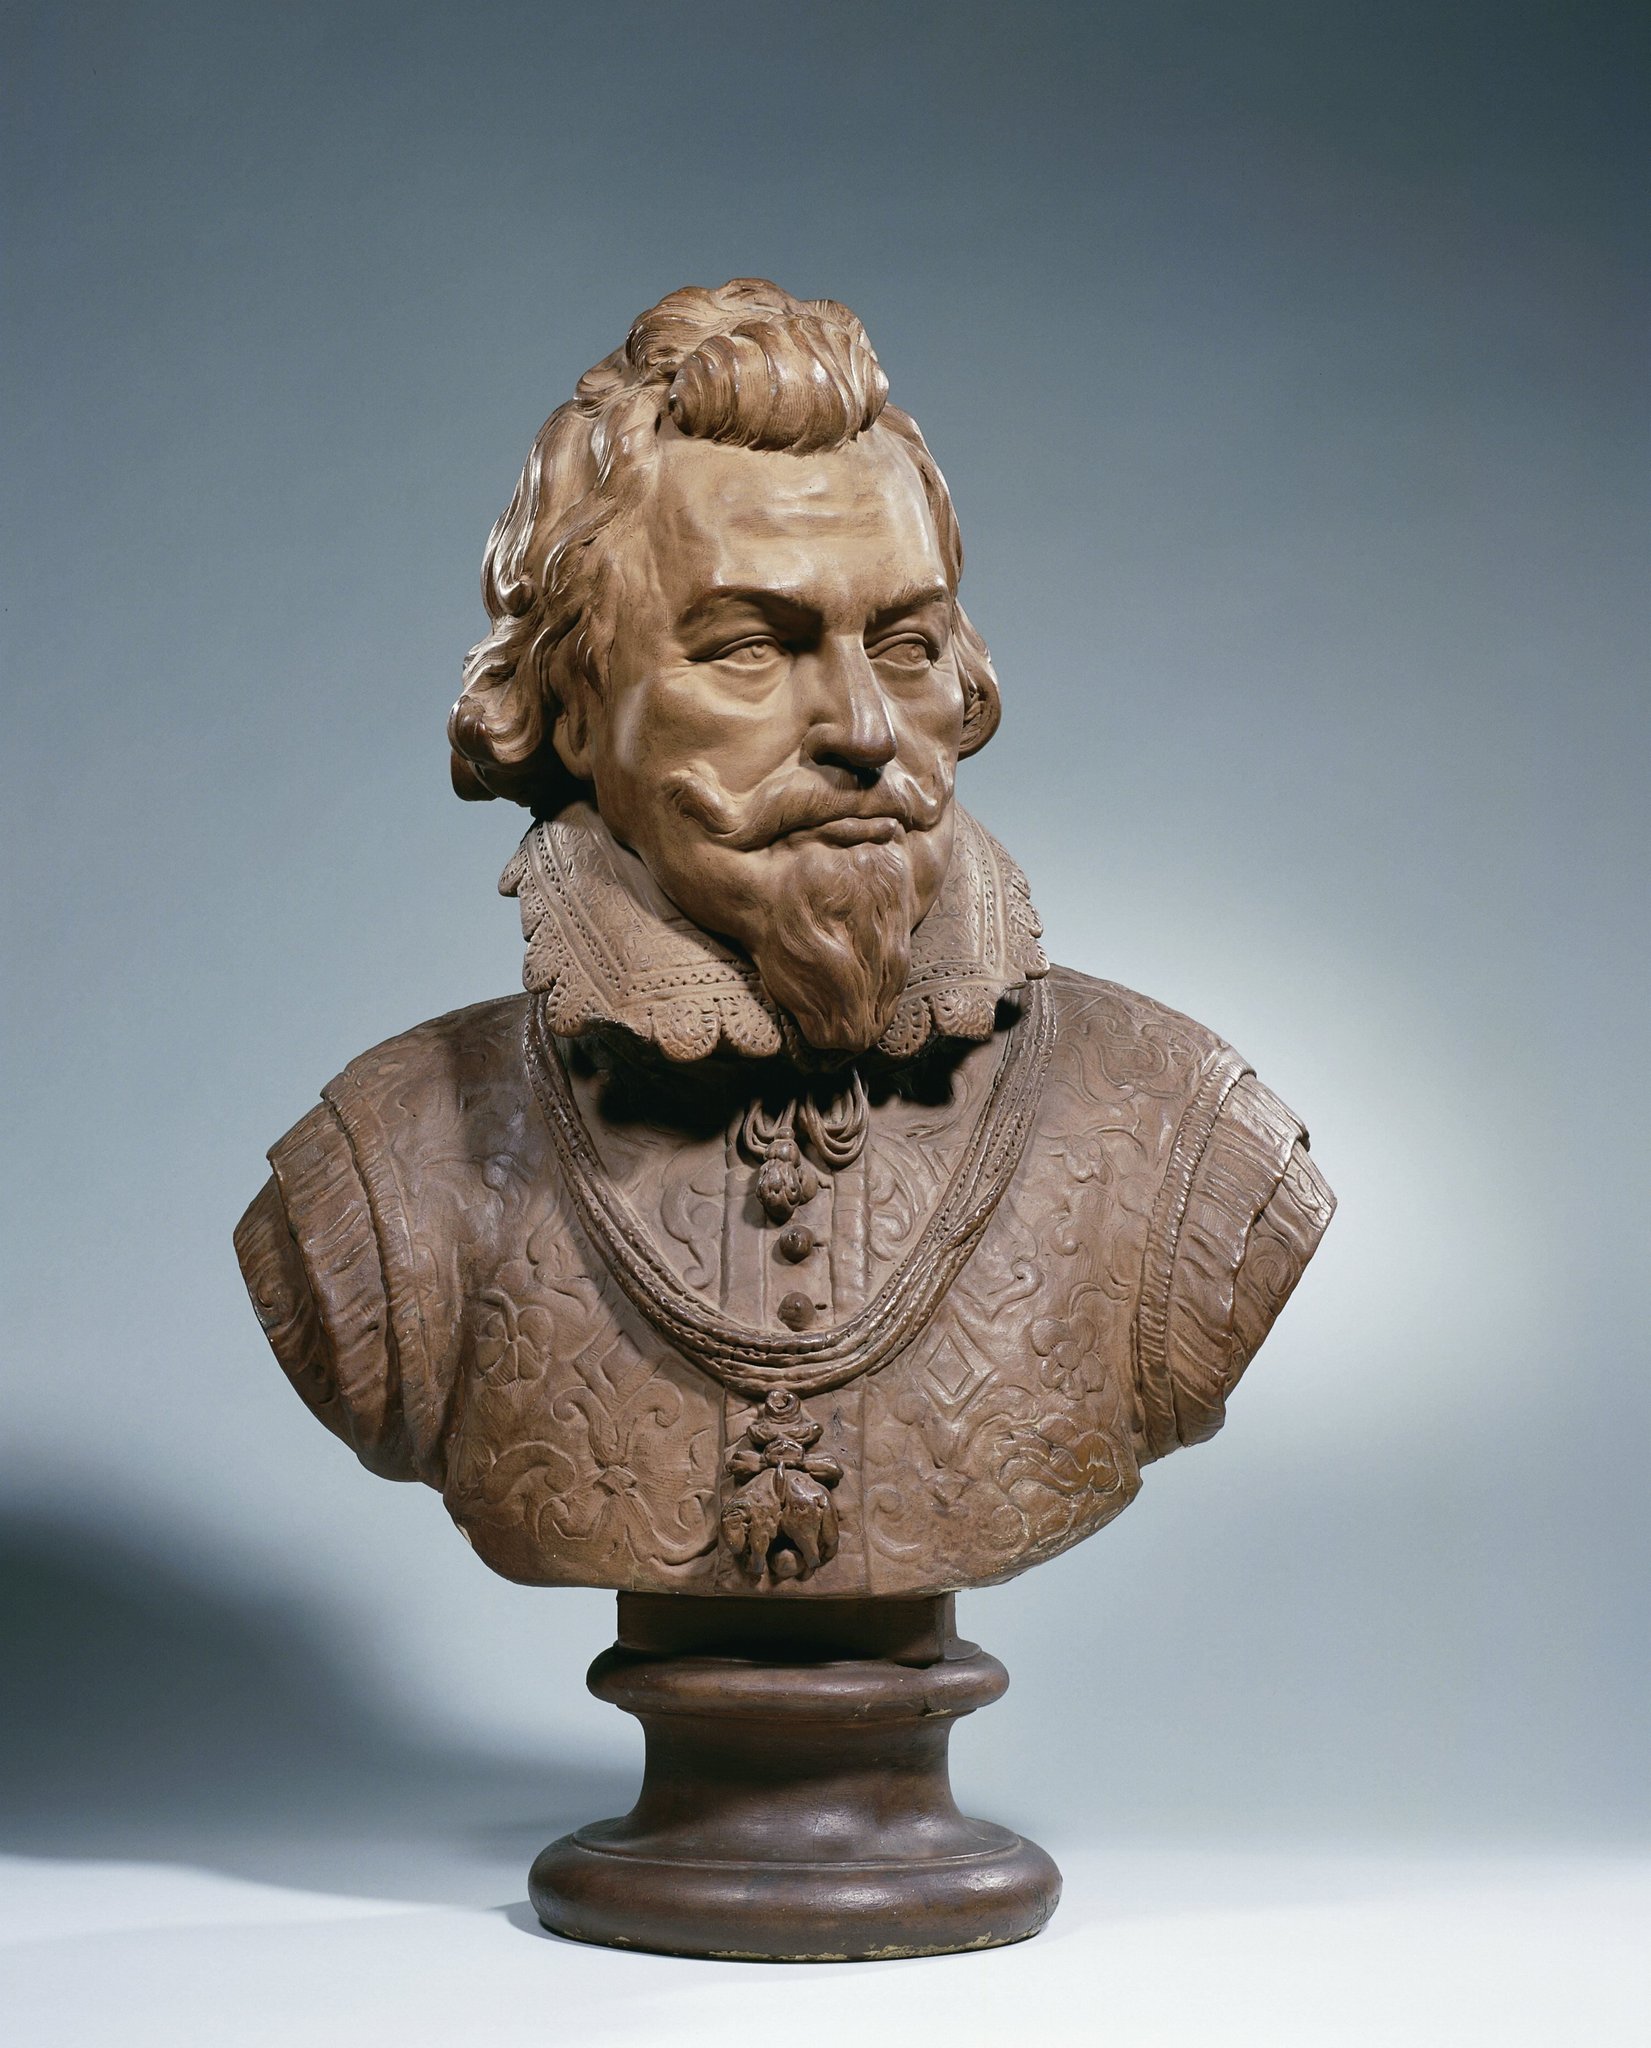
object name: sculpture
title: Philip William, Prince of Orange (1554-1618)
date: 1692-1697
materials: terracotta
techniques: modeling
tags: buren, bruges, filips willem (prins van oranje)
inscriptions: signature and date: ‘Joan Claude de Cock fecit Ao 169..’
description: Prins Philips Willem, oudste zoon van Willem de Zwijger, met hoofd driekwart naar rechts, heeft een baardje en grote knevel. De hals gaat schuil in de openstaande gesteven kanten kraag, die gesloten is met een koordje, waaraan akertjes. Over het met patronen versierde wambuis met opstaand kraagje, dat op de borst met knoopjes wordt gesloten, hangt een vele malen om de hals gewonden ketting met Gulden Vlies; op de schouders schouderkleppen. Het borstbeeld, dat even onder schouders en borst eindigt, heeft een gedraaid voetstuk. Tegen de holle achterzijde in schrijfletters signatuur en datum.